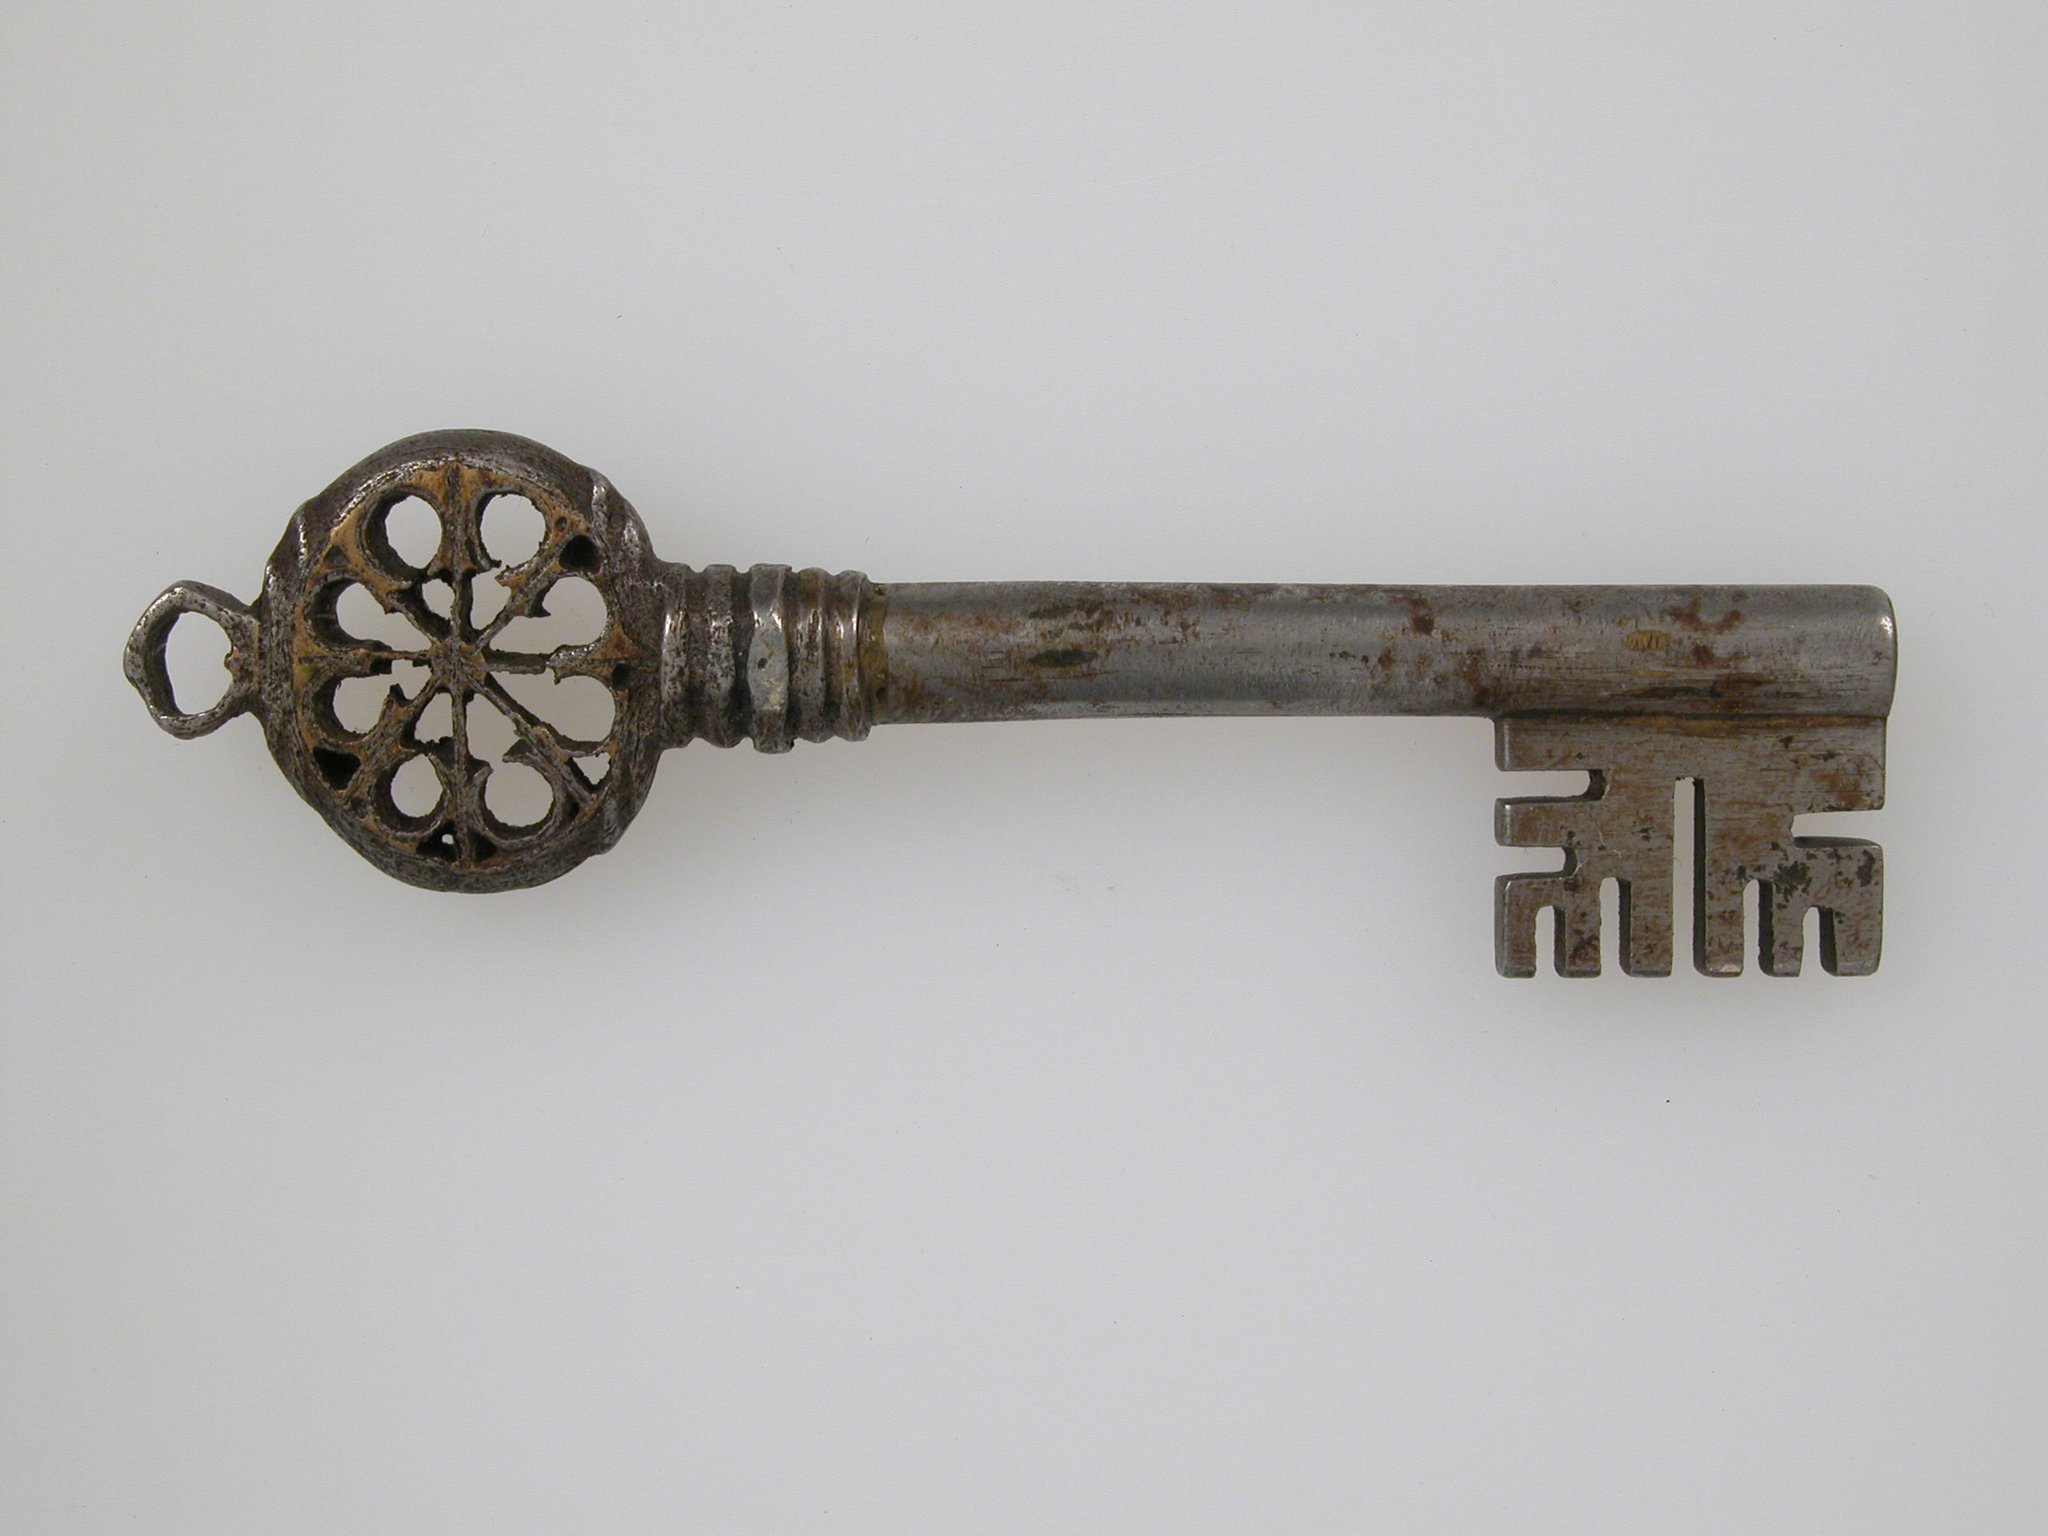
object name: key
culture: german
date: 1401-1500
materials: iron